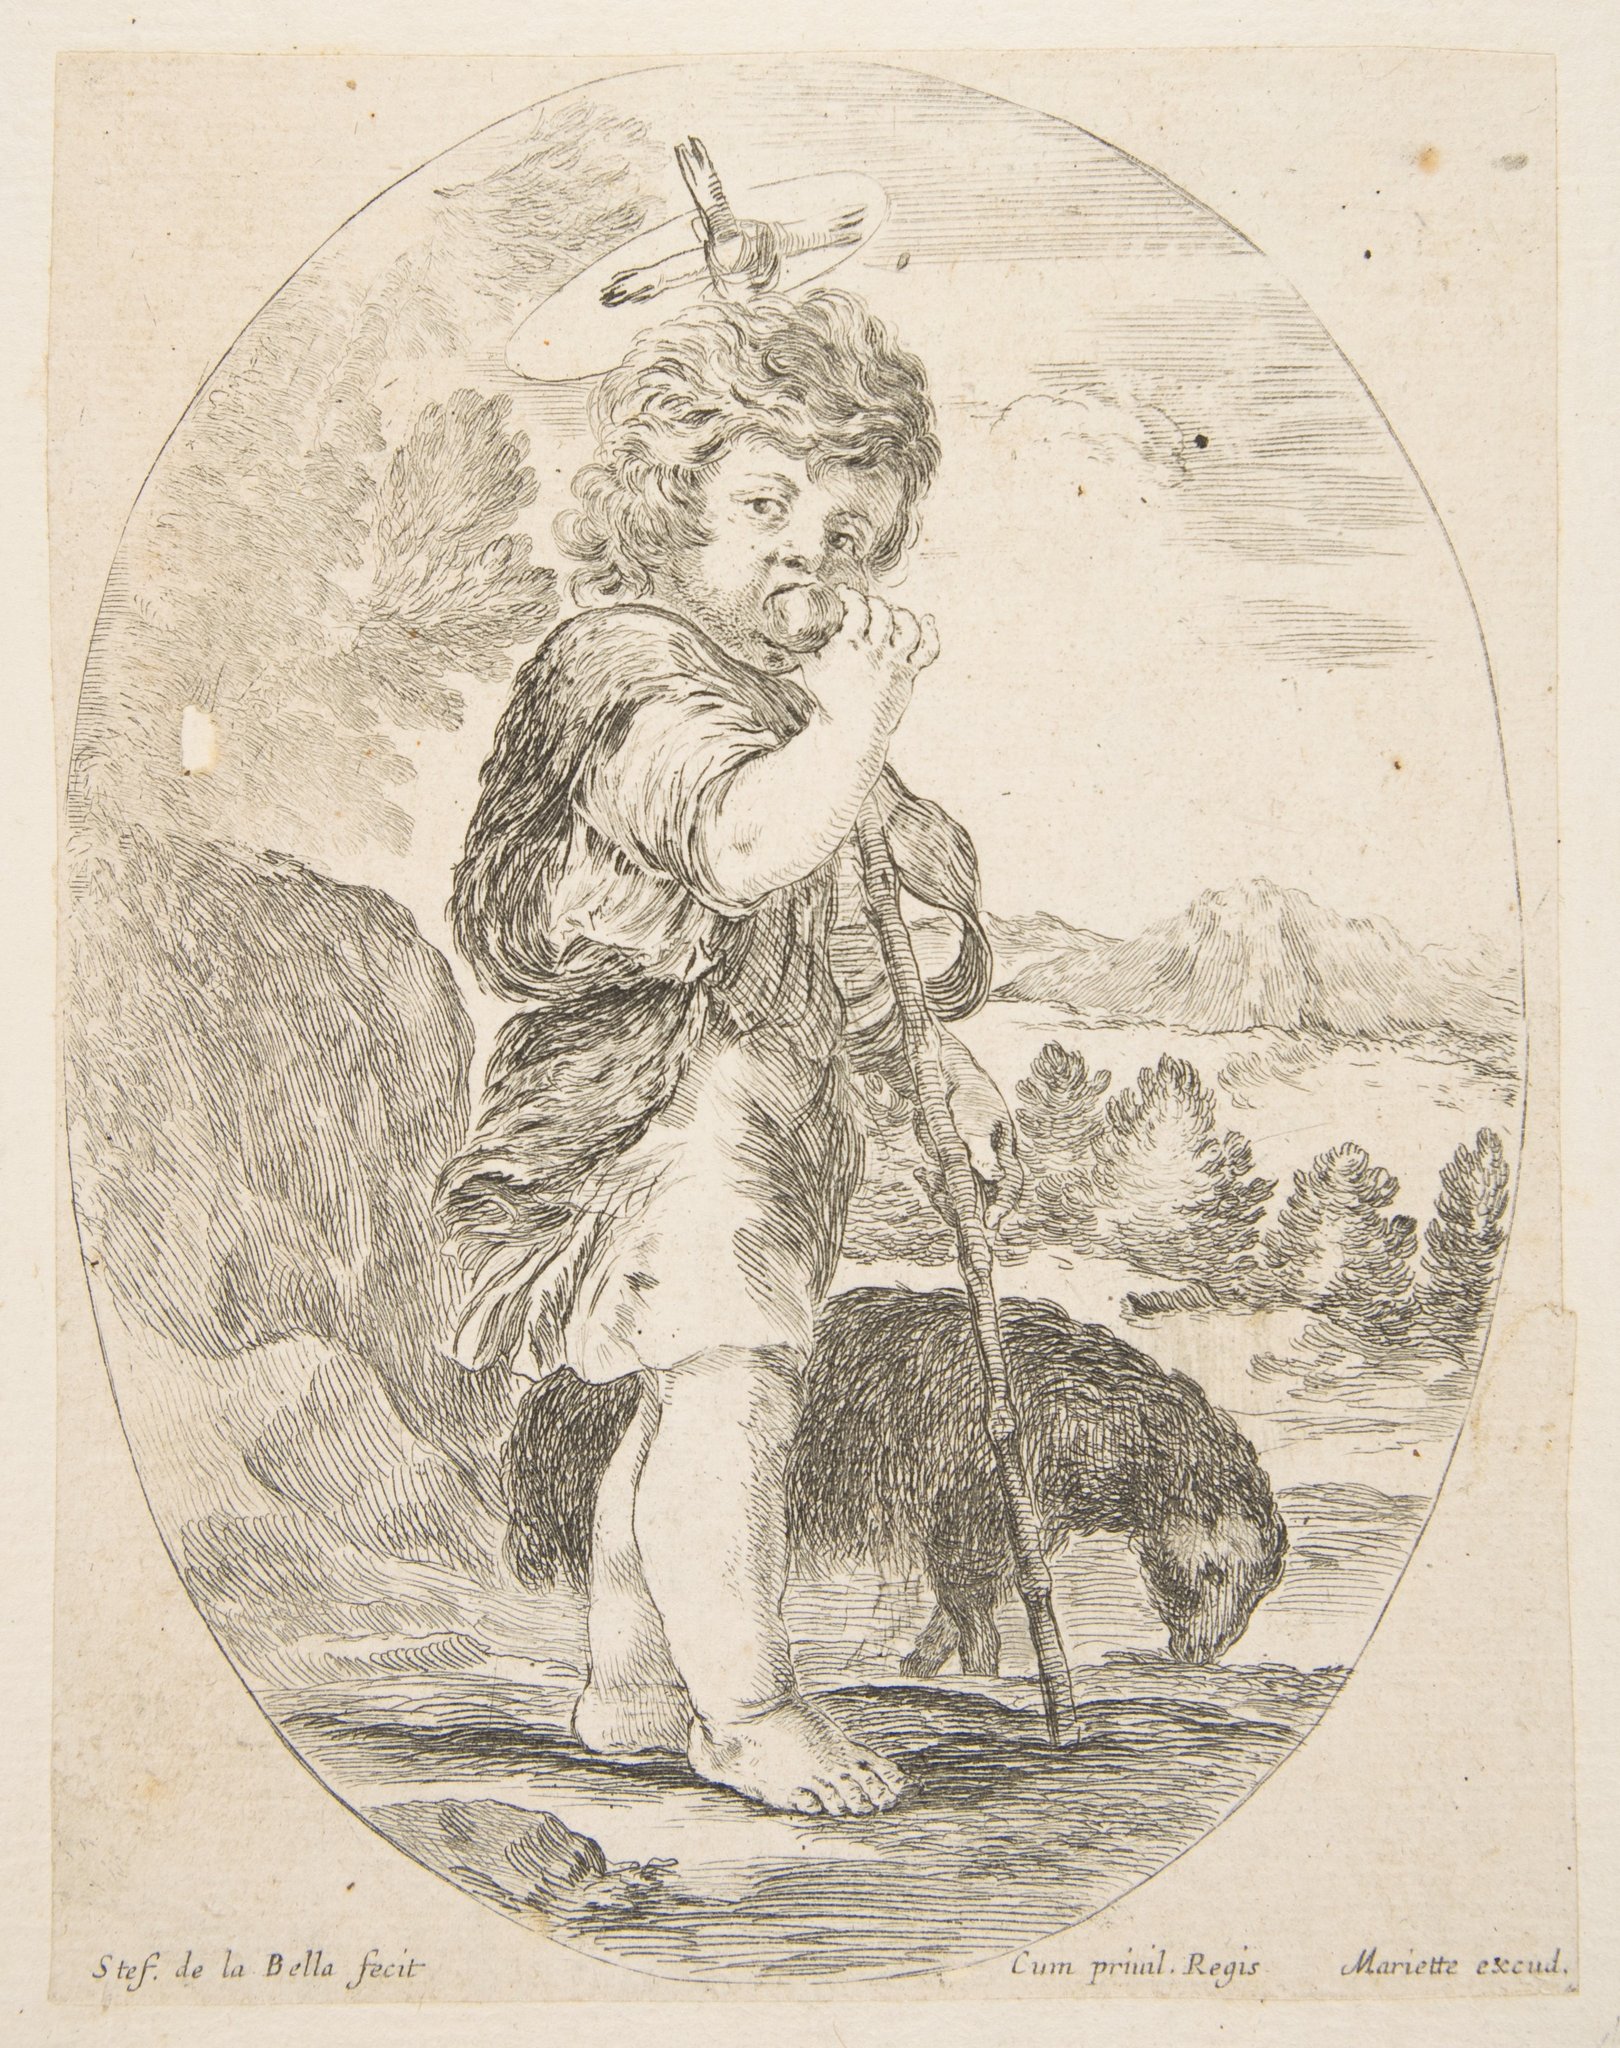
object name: print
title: Saint John the Baptist eating a piece of fruit, an oval composition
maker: stefano della bella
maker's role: artist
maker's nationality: italian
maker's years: 1610-1664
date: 1641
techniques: etching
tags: animals,fruit,saint john the baptist